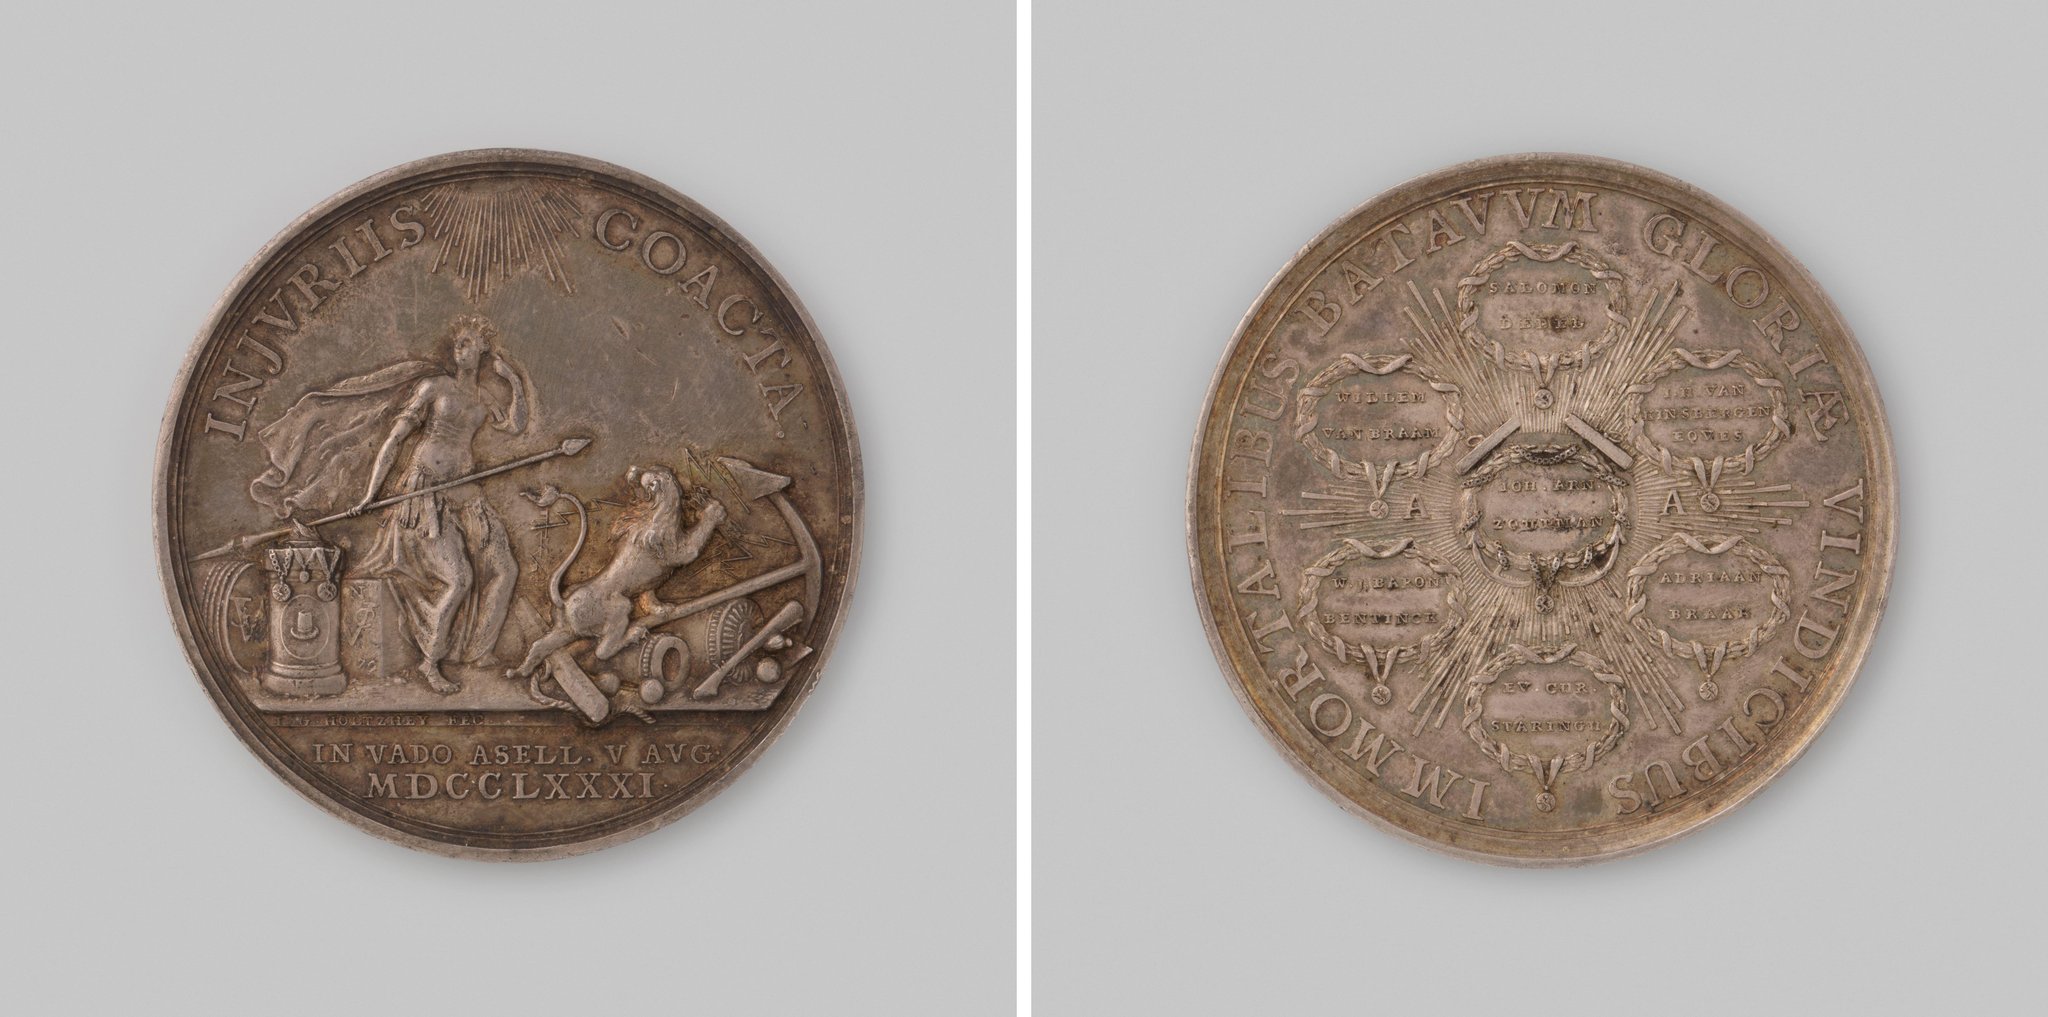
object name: history medal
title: Slag bij de Doggersbank 1781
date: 1781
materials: silver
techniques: pressing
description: Zilveren penning, op de voorzijde de Nederlandse Maagd met scheepskroon, mantel en piek onder een stralende hemel, met rechts de Nederlandse Leeuw die, staand op een anker en enkele kanonnen, met zijn bliksemende pijlenbundel tegen oorlogsschepen tekeer gaat, en links een altaar waaraan drie beloningspenningen hangen te midden van handelswaar van VOC en GWC, met omschrift en afsnedetekst, op de keerzijde, op een ster van stralen, een kring van zes ovale kransen met de namen van bevelvoerders omhangen met hun beloningspenning, met in het midden de krans van Zoutman op twee gekruiste ankers tussn A - A, met omschrift.